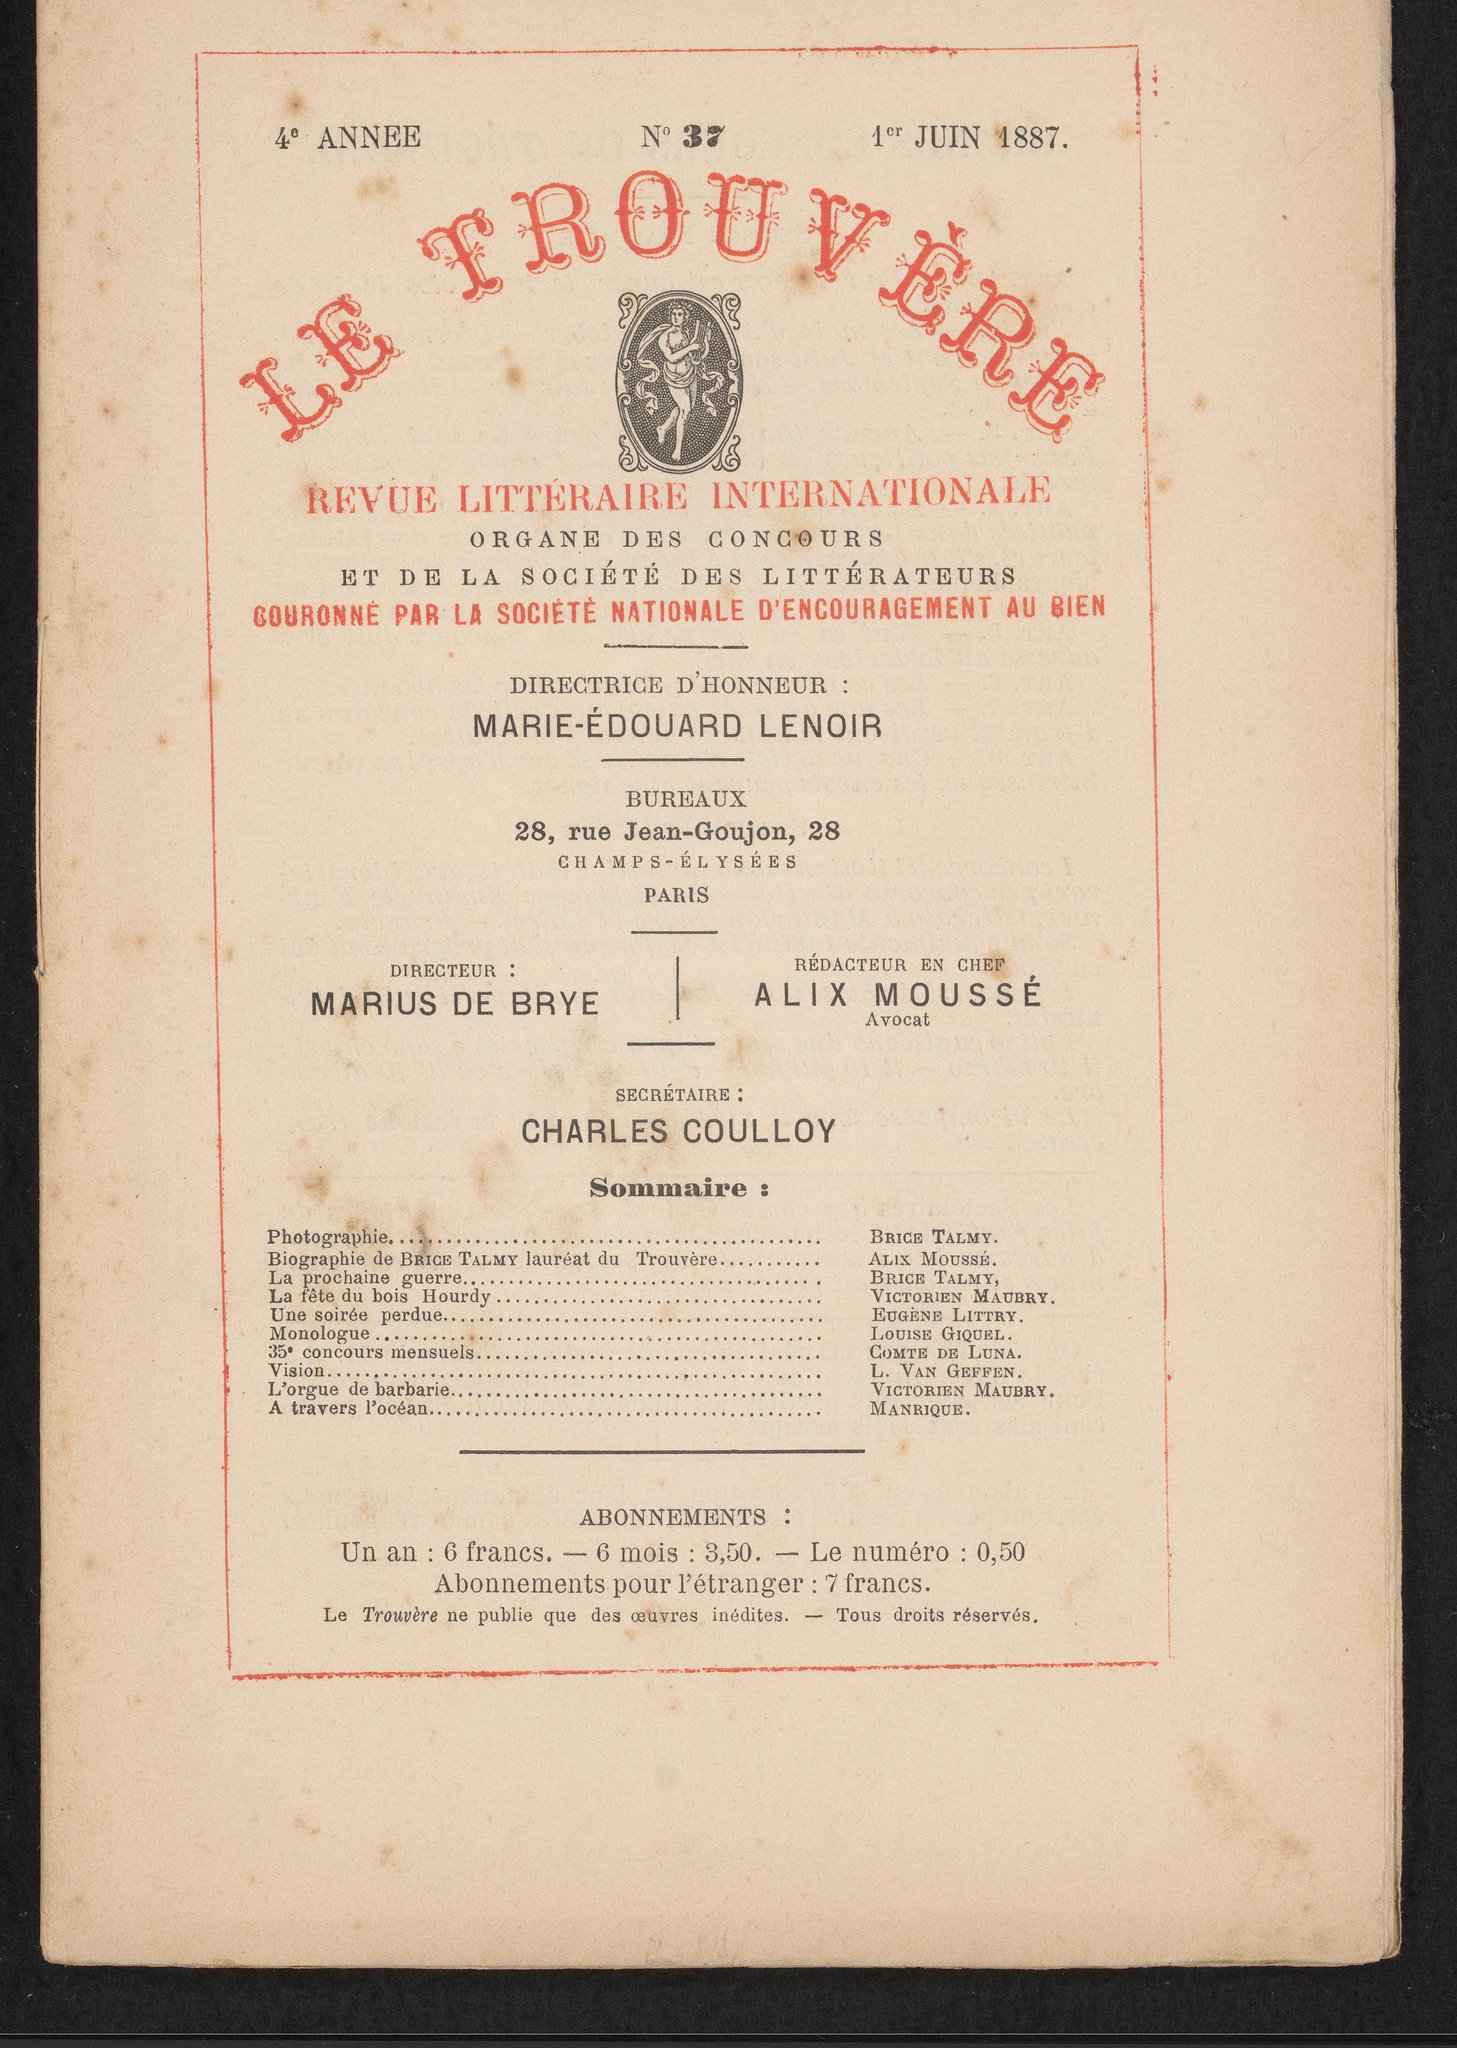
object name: book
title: Le trouvère No 37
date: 1806-1887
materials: paper, photographic support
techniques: albumen print, printing, engraving